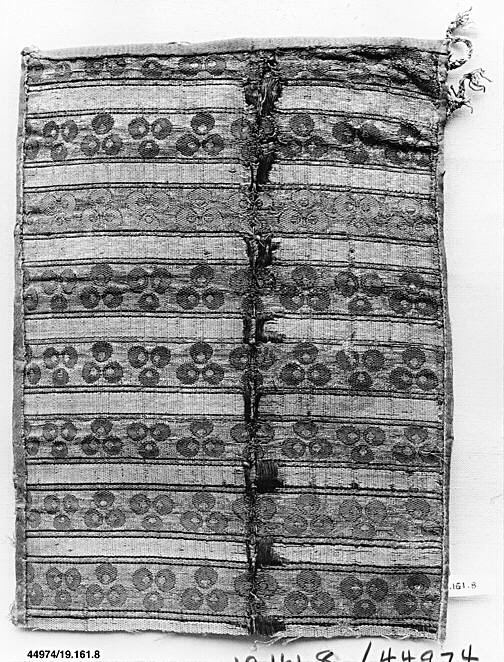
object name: textile fragment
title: Brocade Fragment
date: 1501-1533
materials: metal thread, silk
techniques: brocade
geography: turkey